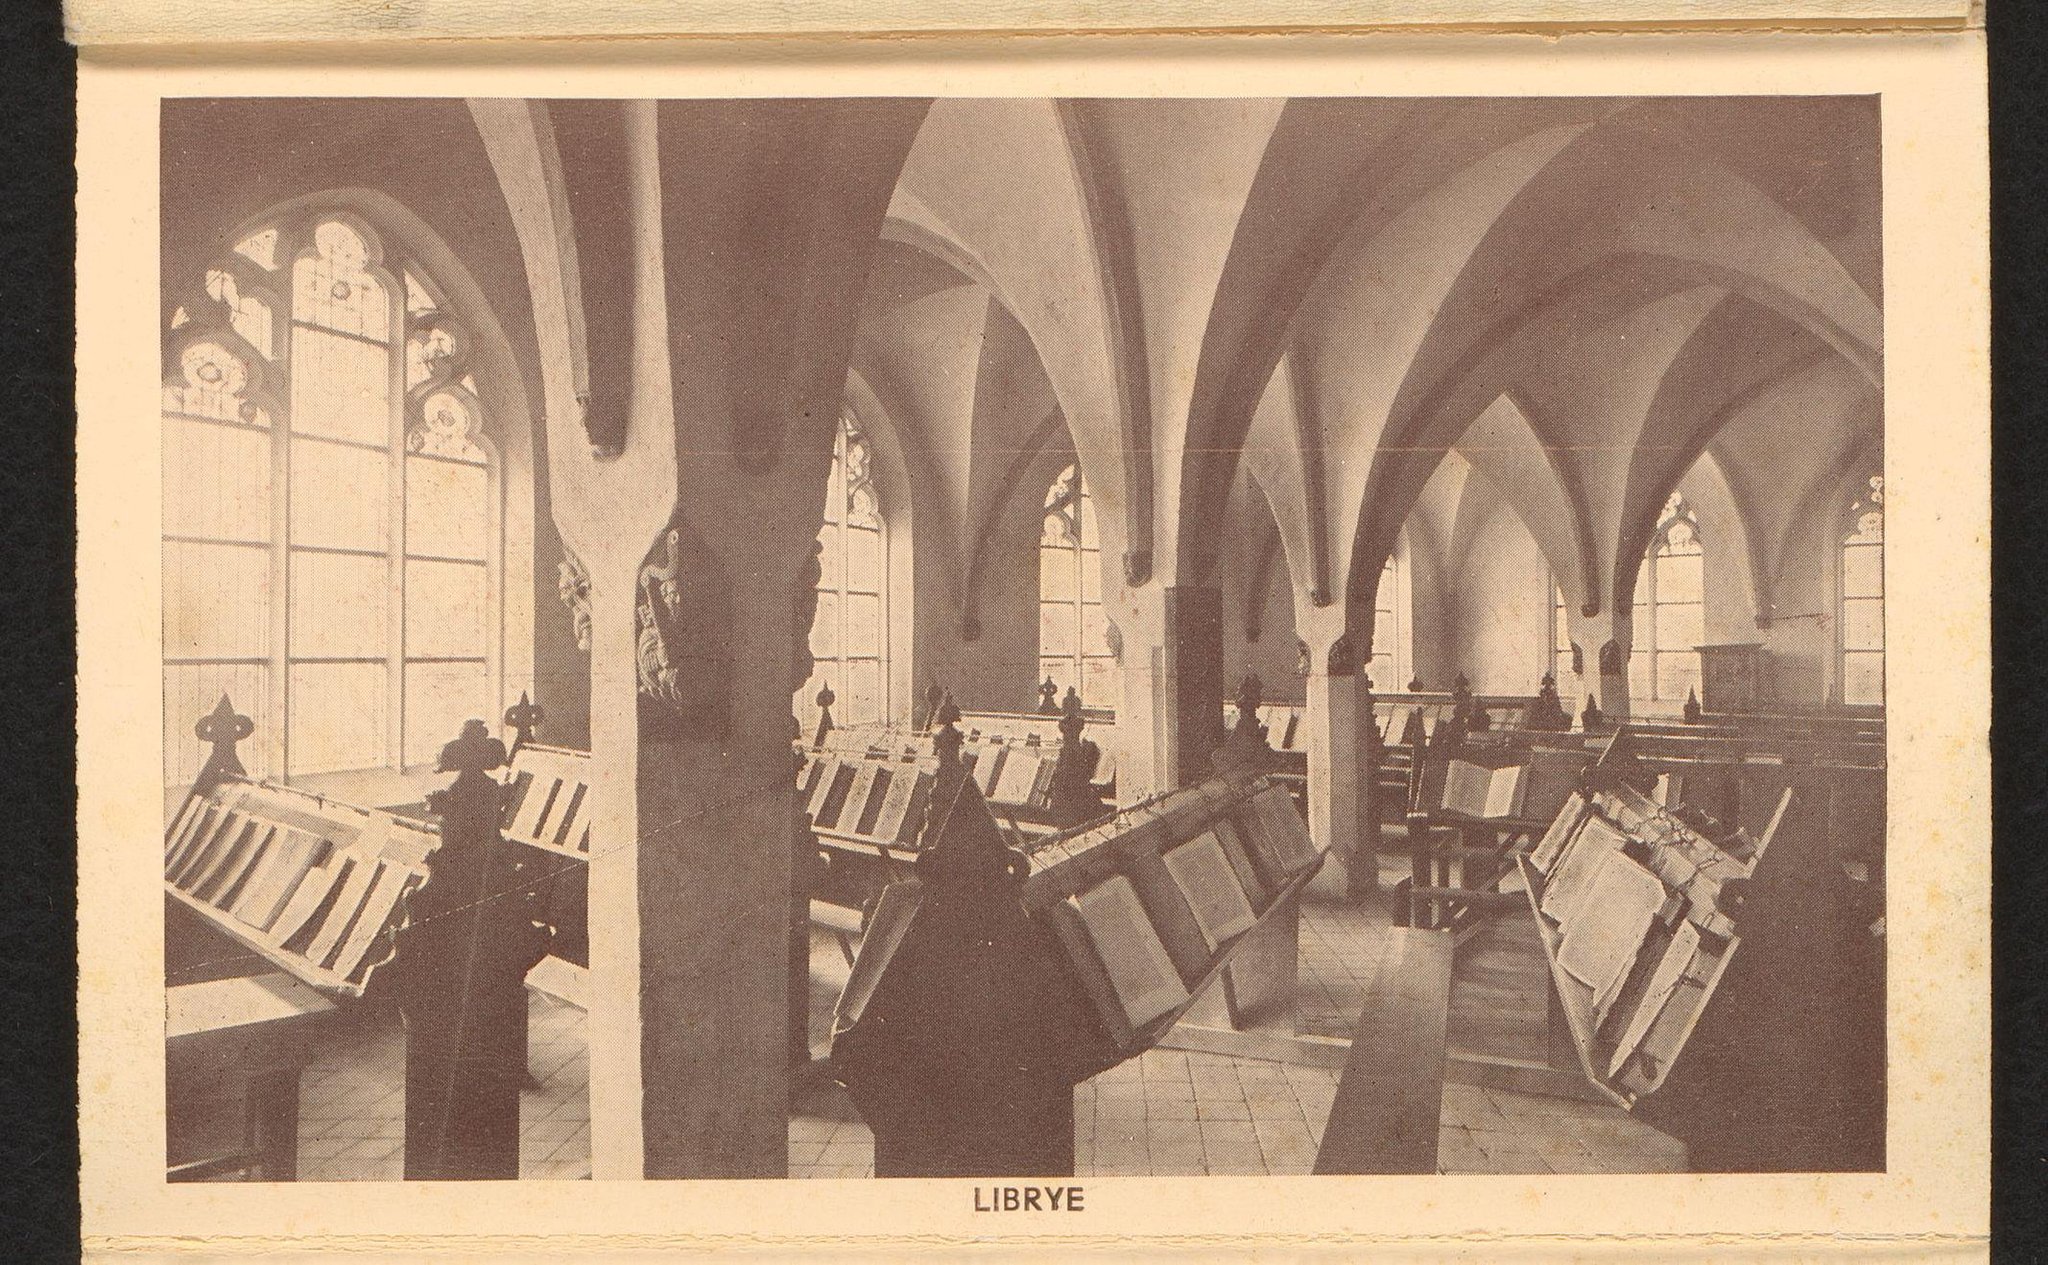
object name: photomechanical print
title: Librye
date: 1925-1940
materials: cardboard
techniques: autotype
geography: zutphen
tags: study; 'studiolo'; library, interior of church